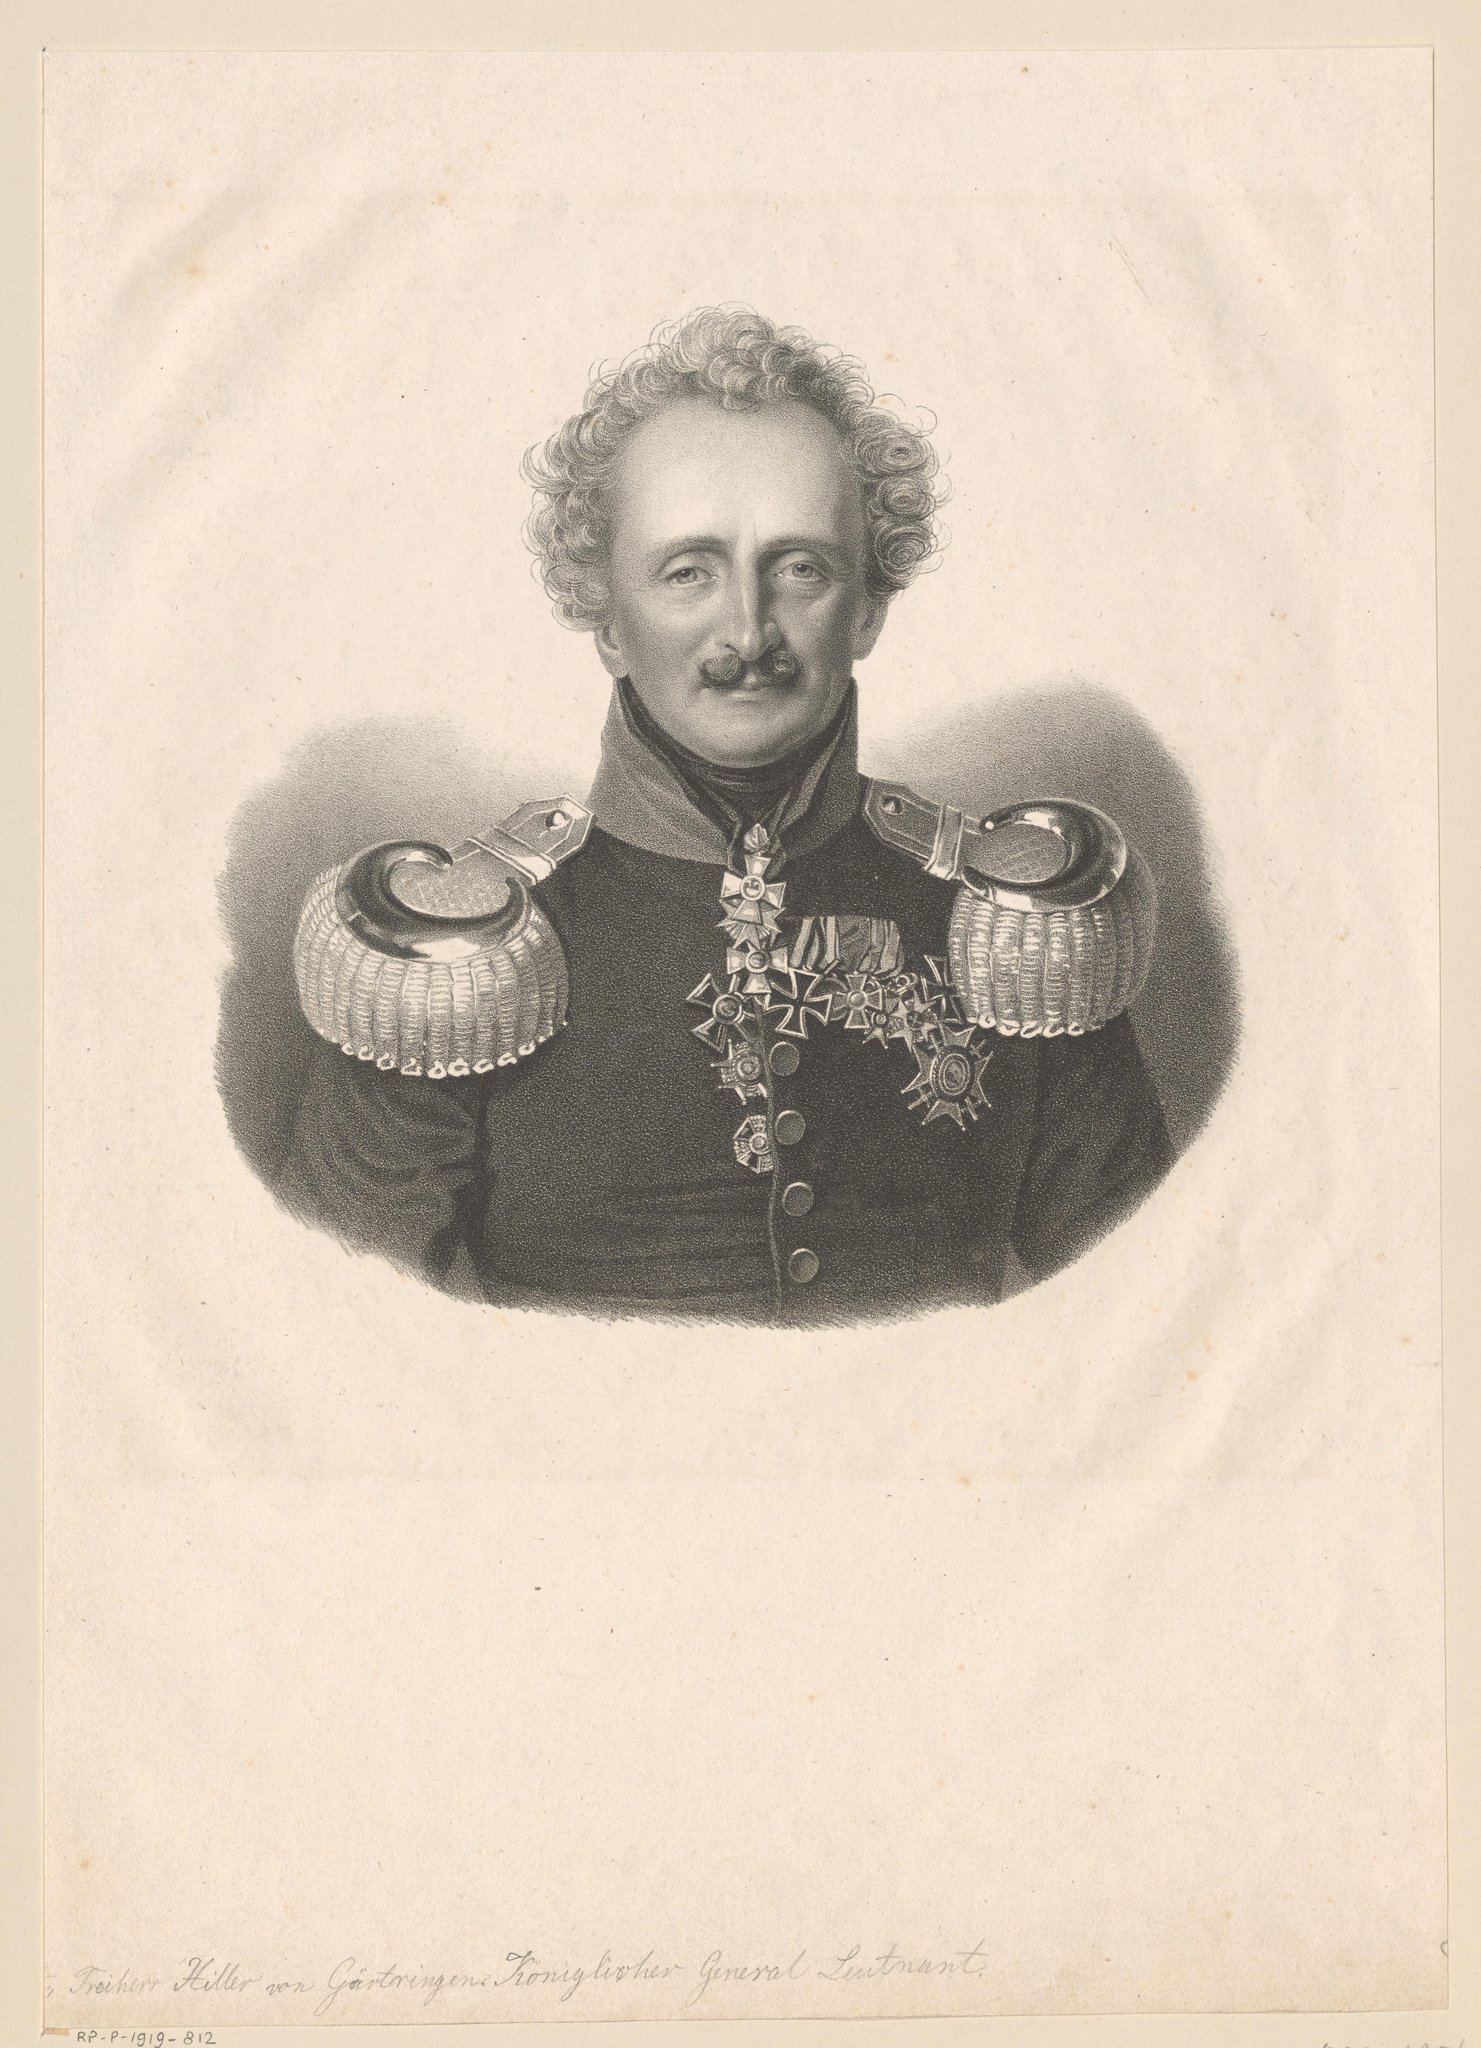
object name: print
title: Portret van August Hiller von Gaertringen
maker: Anonymous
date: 1830-1870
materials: paper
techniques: lithograph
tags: commander-in-chief, general, marshal, historical persons, medals and other marks of military honour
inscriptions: collector's mark: Lugt 2228